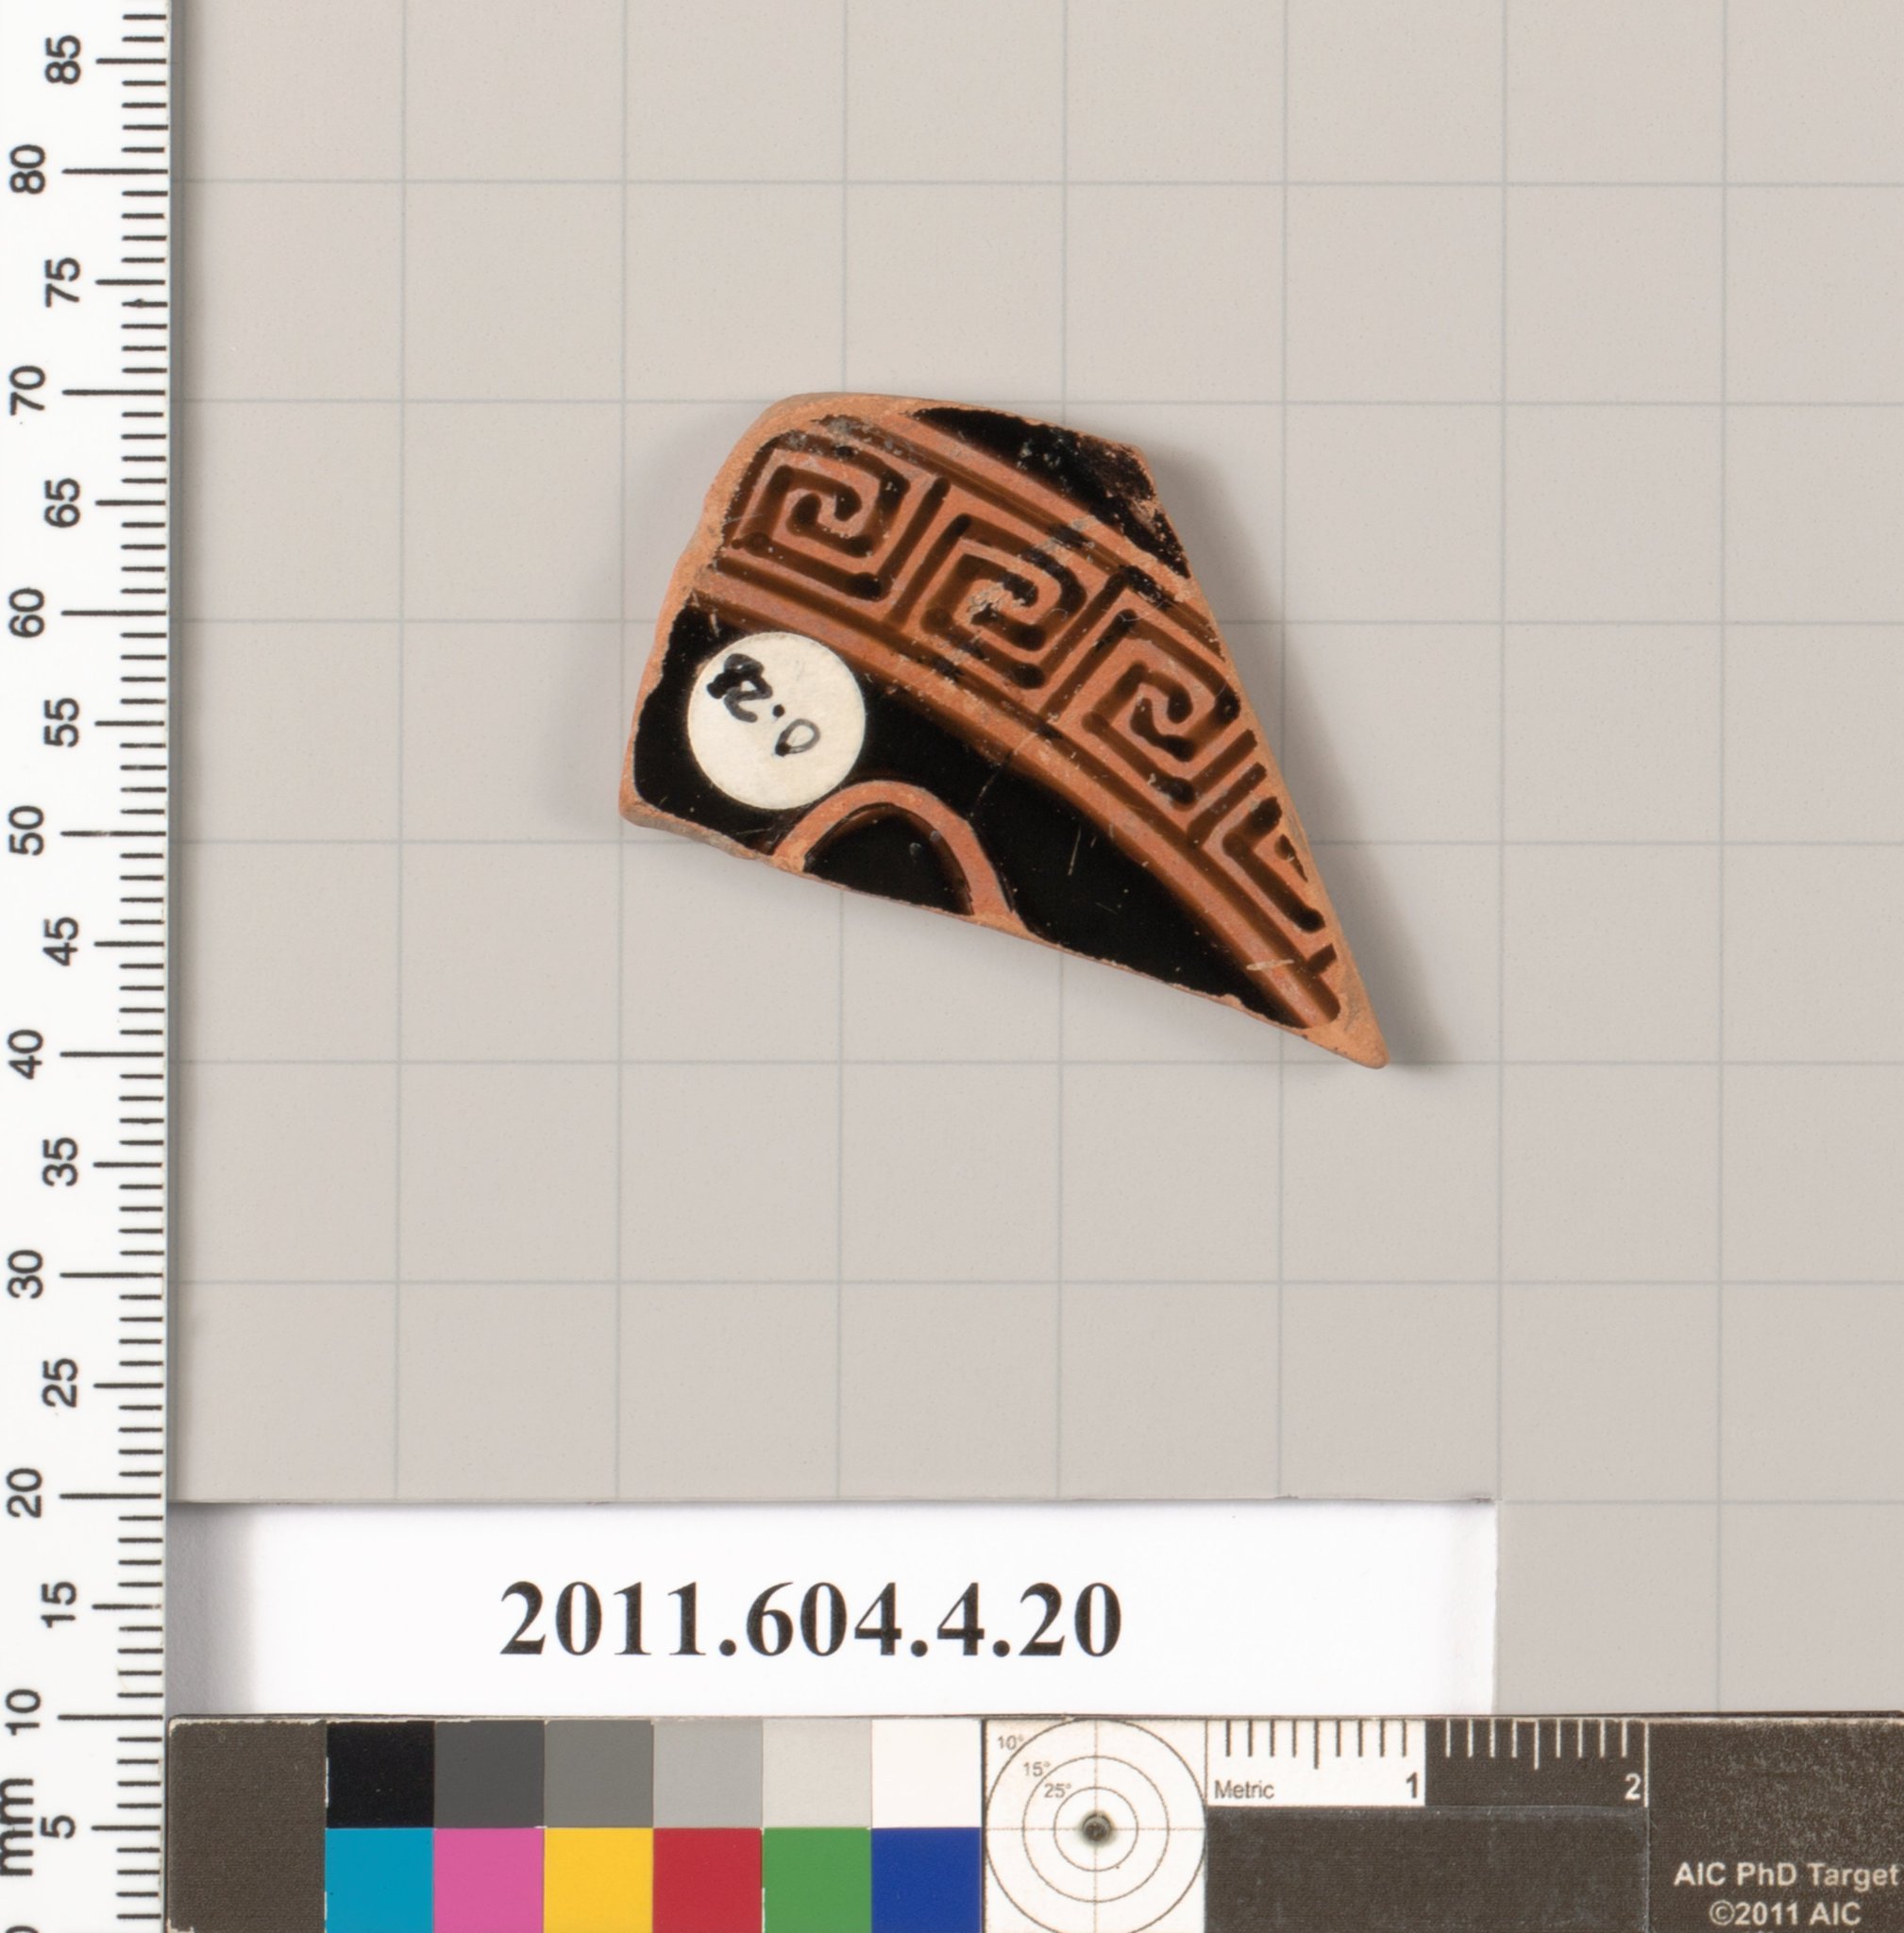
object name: kylix fragment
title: Terracotta fragment of a kylix (drinking cup)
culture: greek, attic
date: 500-401 BCE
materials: terracotta